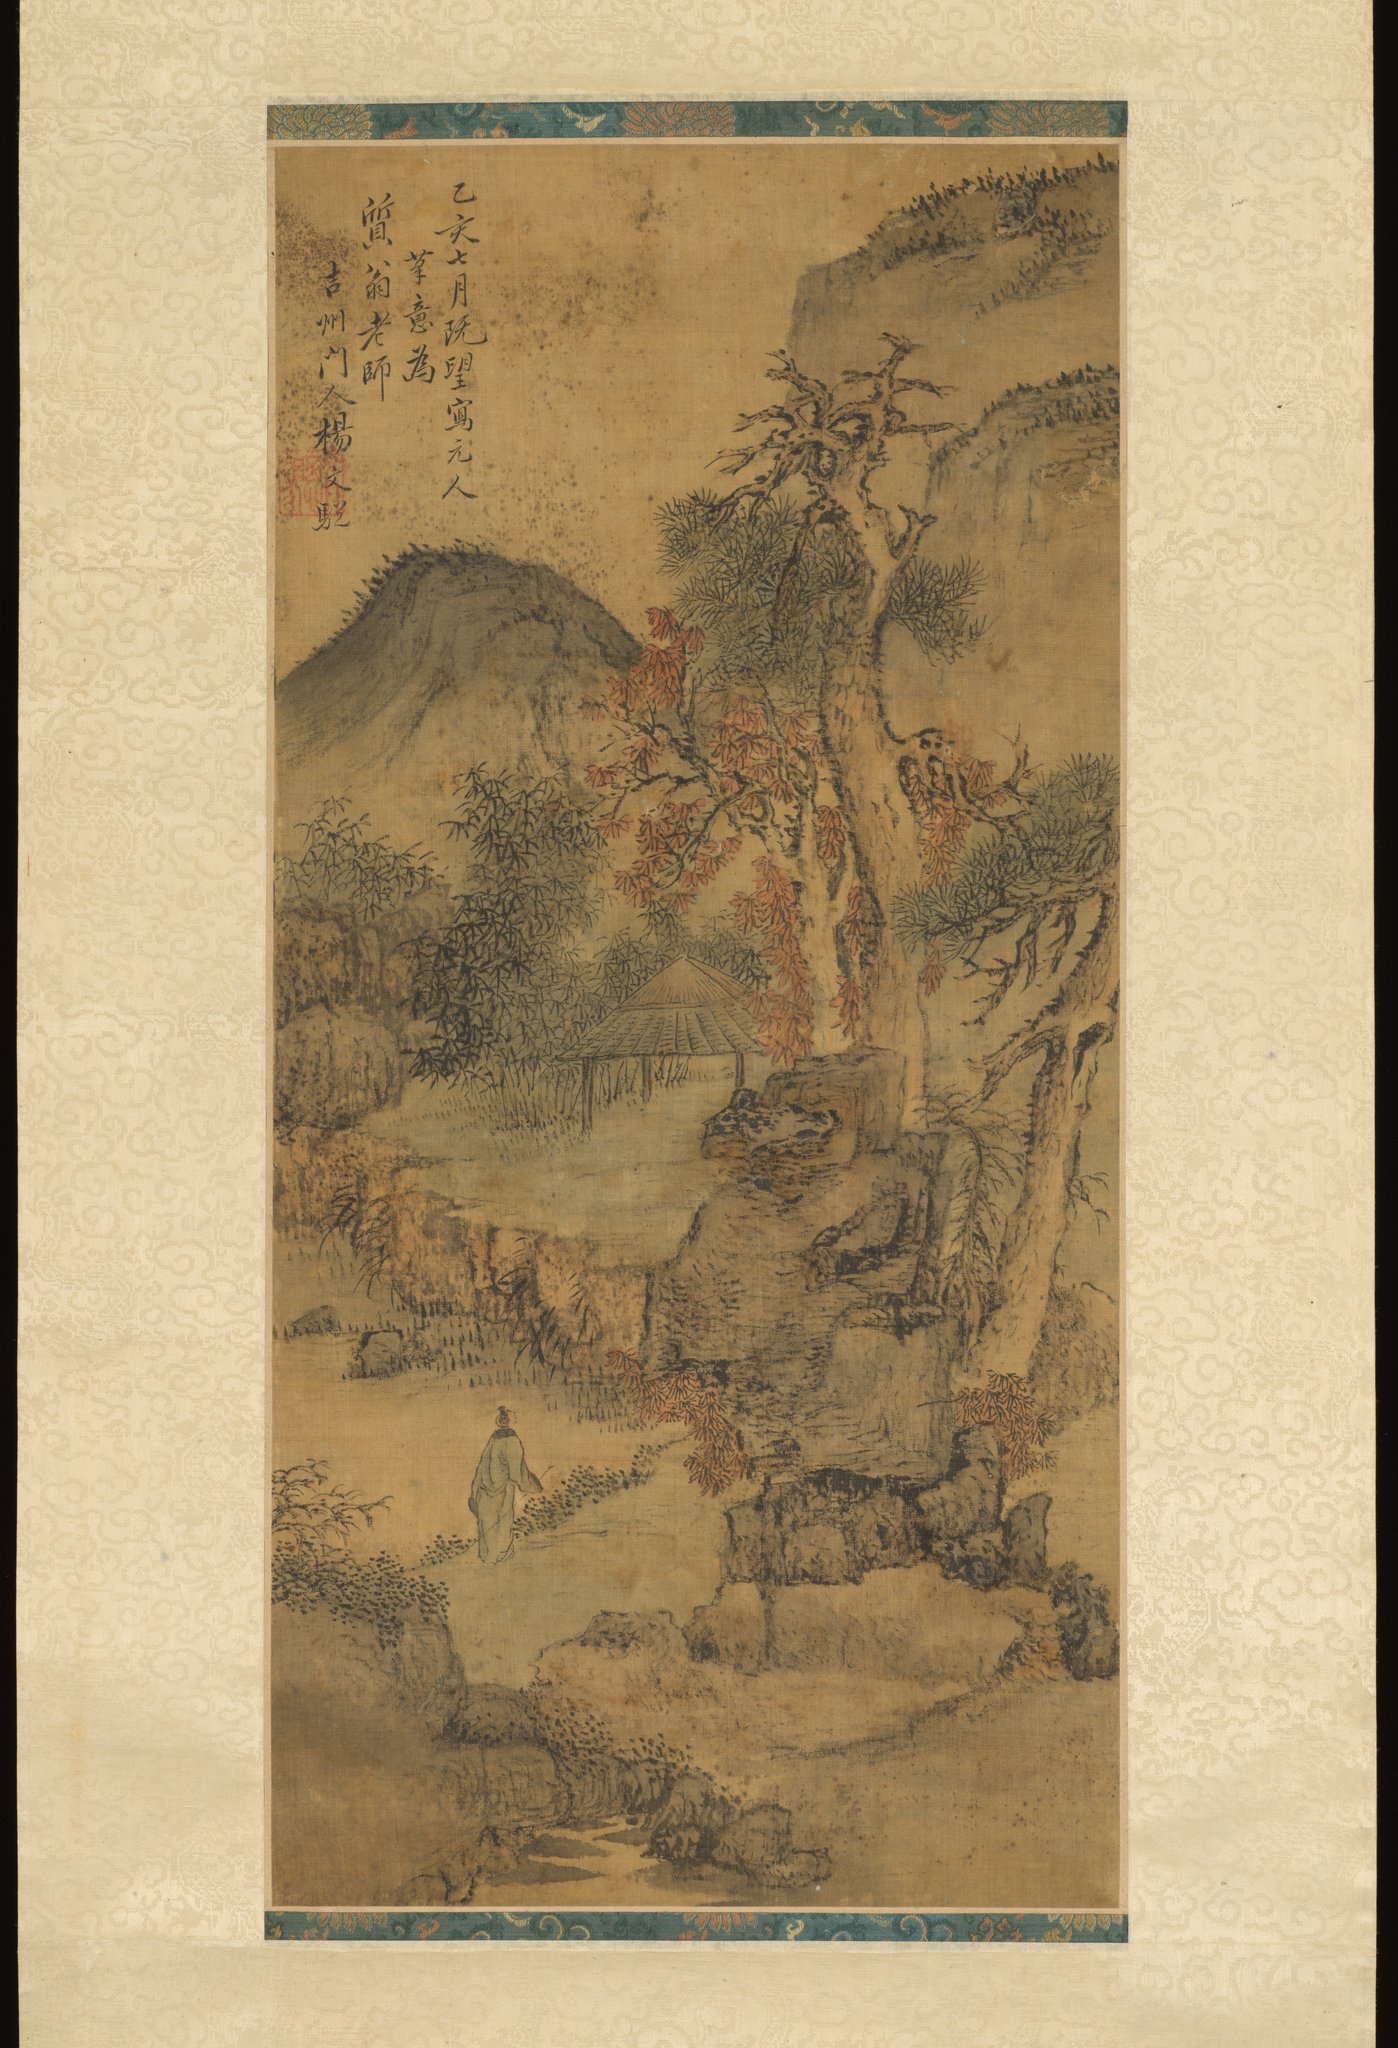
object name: hanging scroll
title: Landscape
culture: chinese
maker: yang wencong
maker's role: artist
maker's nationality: chinese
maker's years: 1597-1646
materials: ink, silk